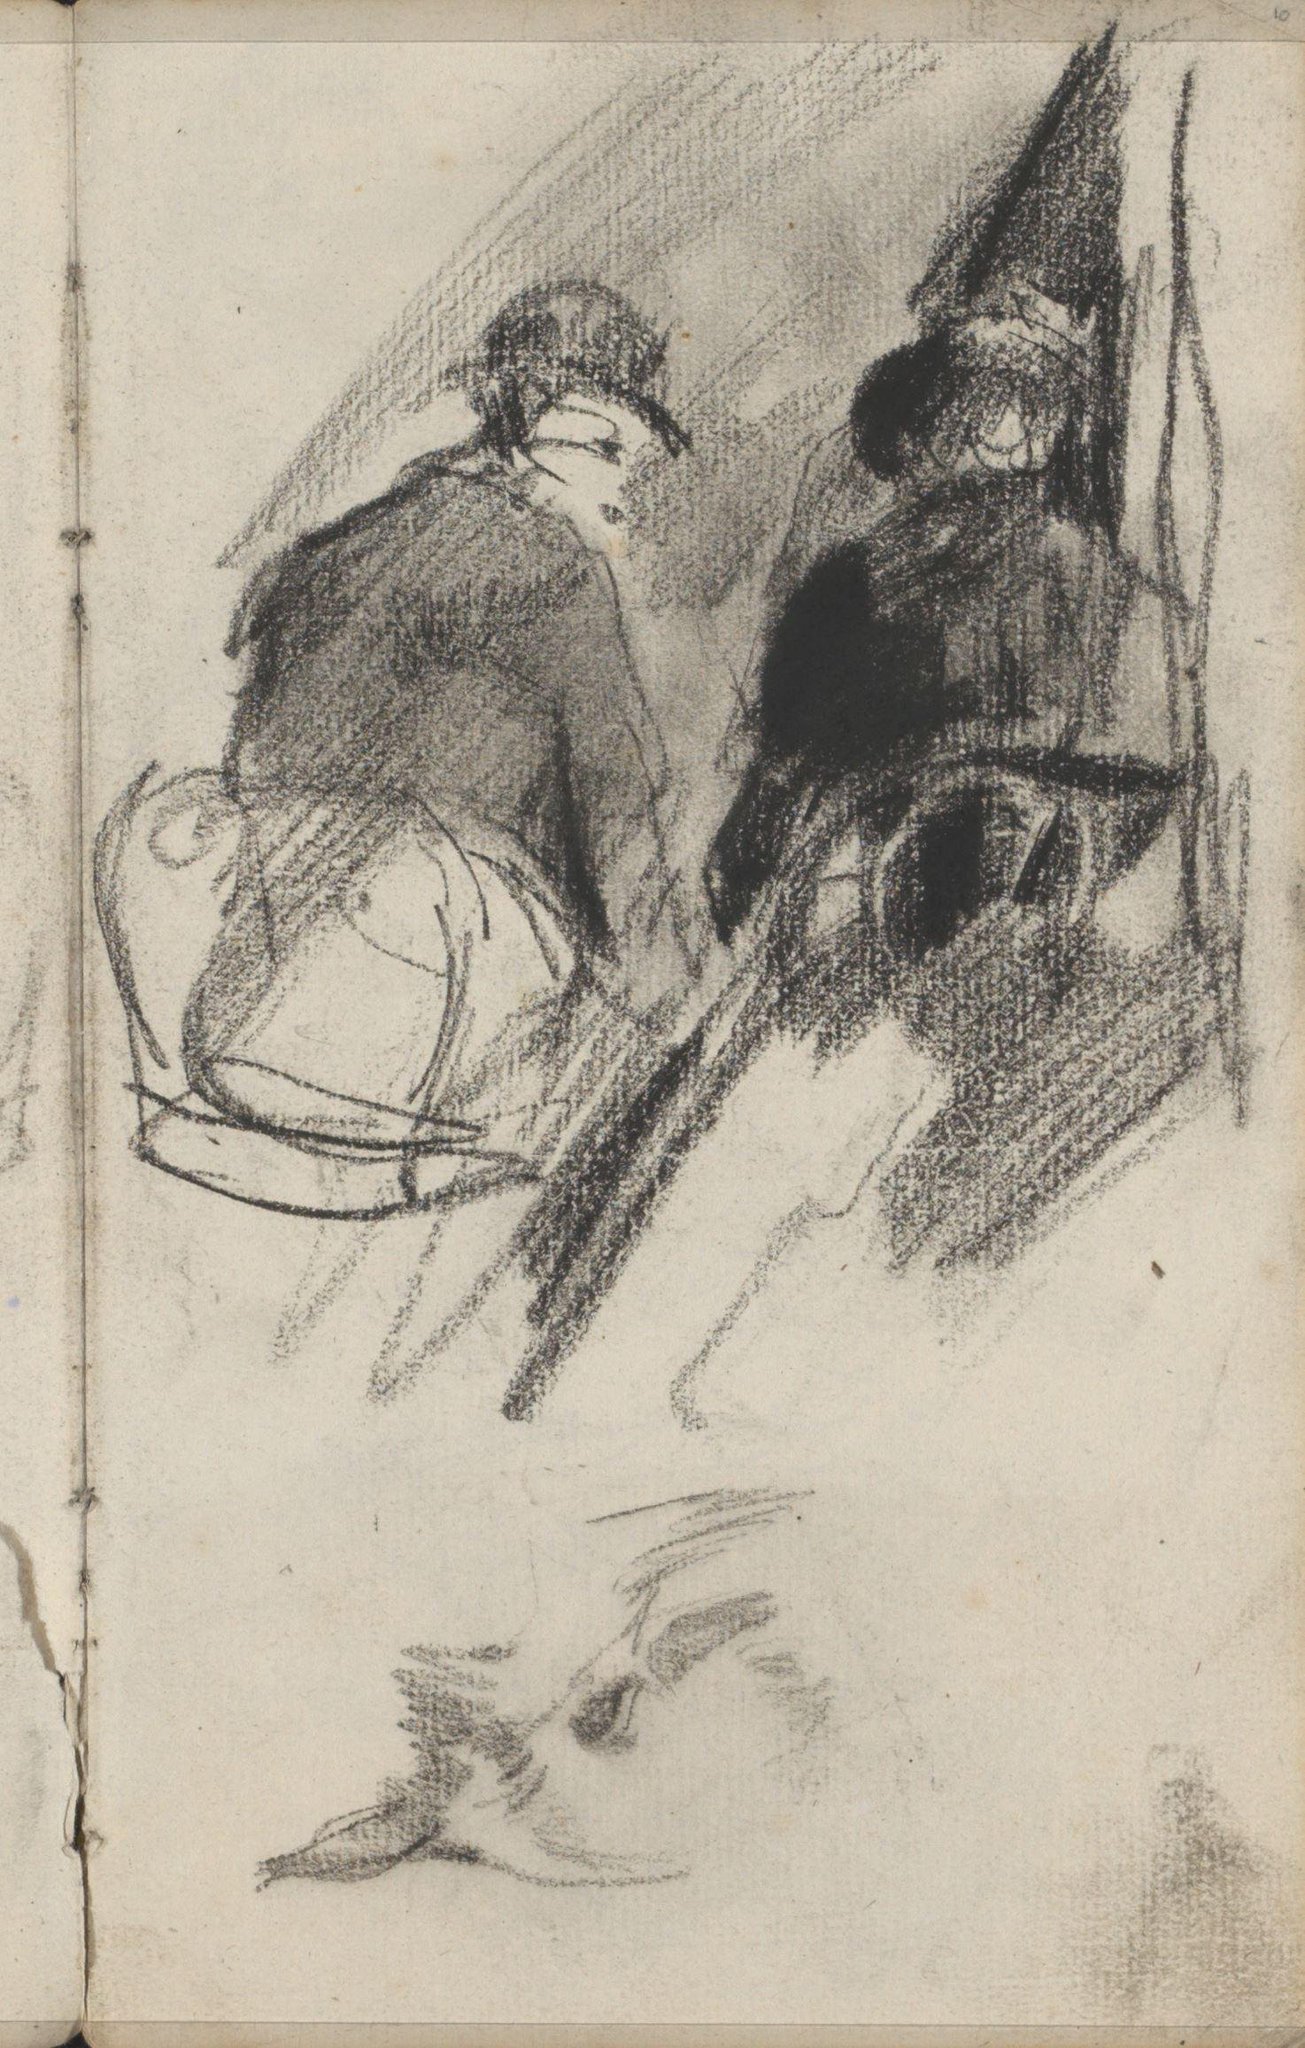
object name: sketchbook leaf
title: Vogelkop en twee figuurstudies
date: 1881-1883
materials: chalk, paper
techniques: stumping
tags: birds, adult man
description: Pagina 10 uit een schetsboek met 27 bladen.